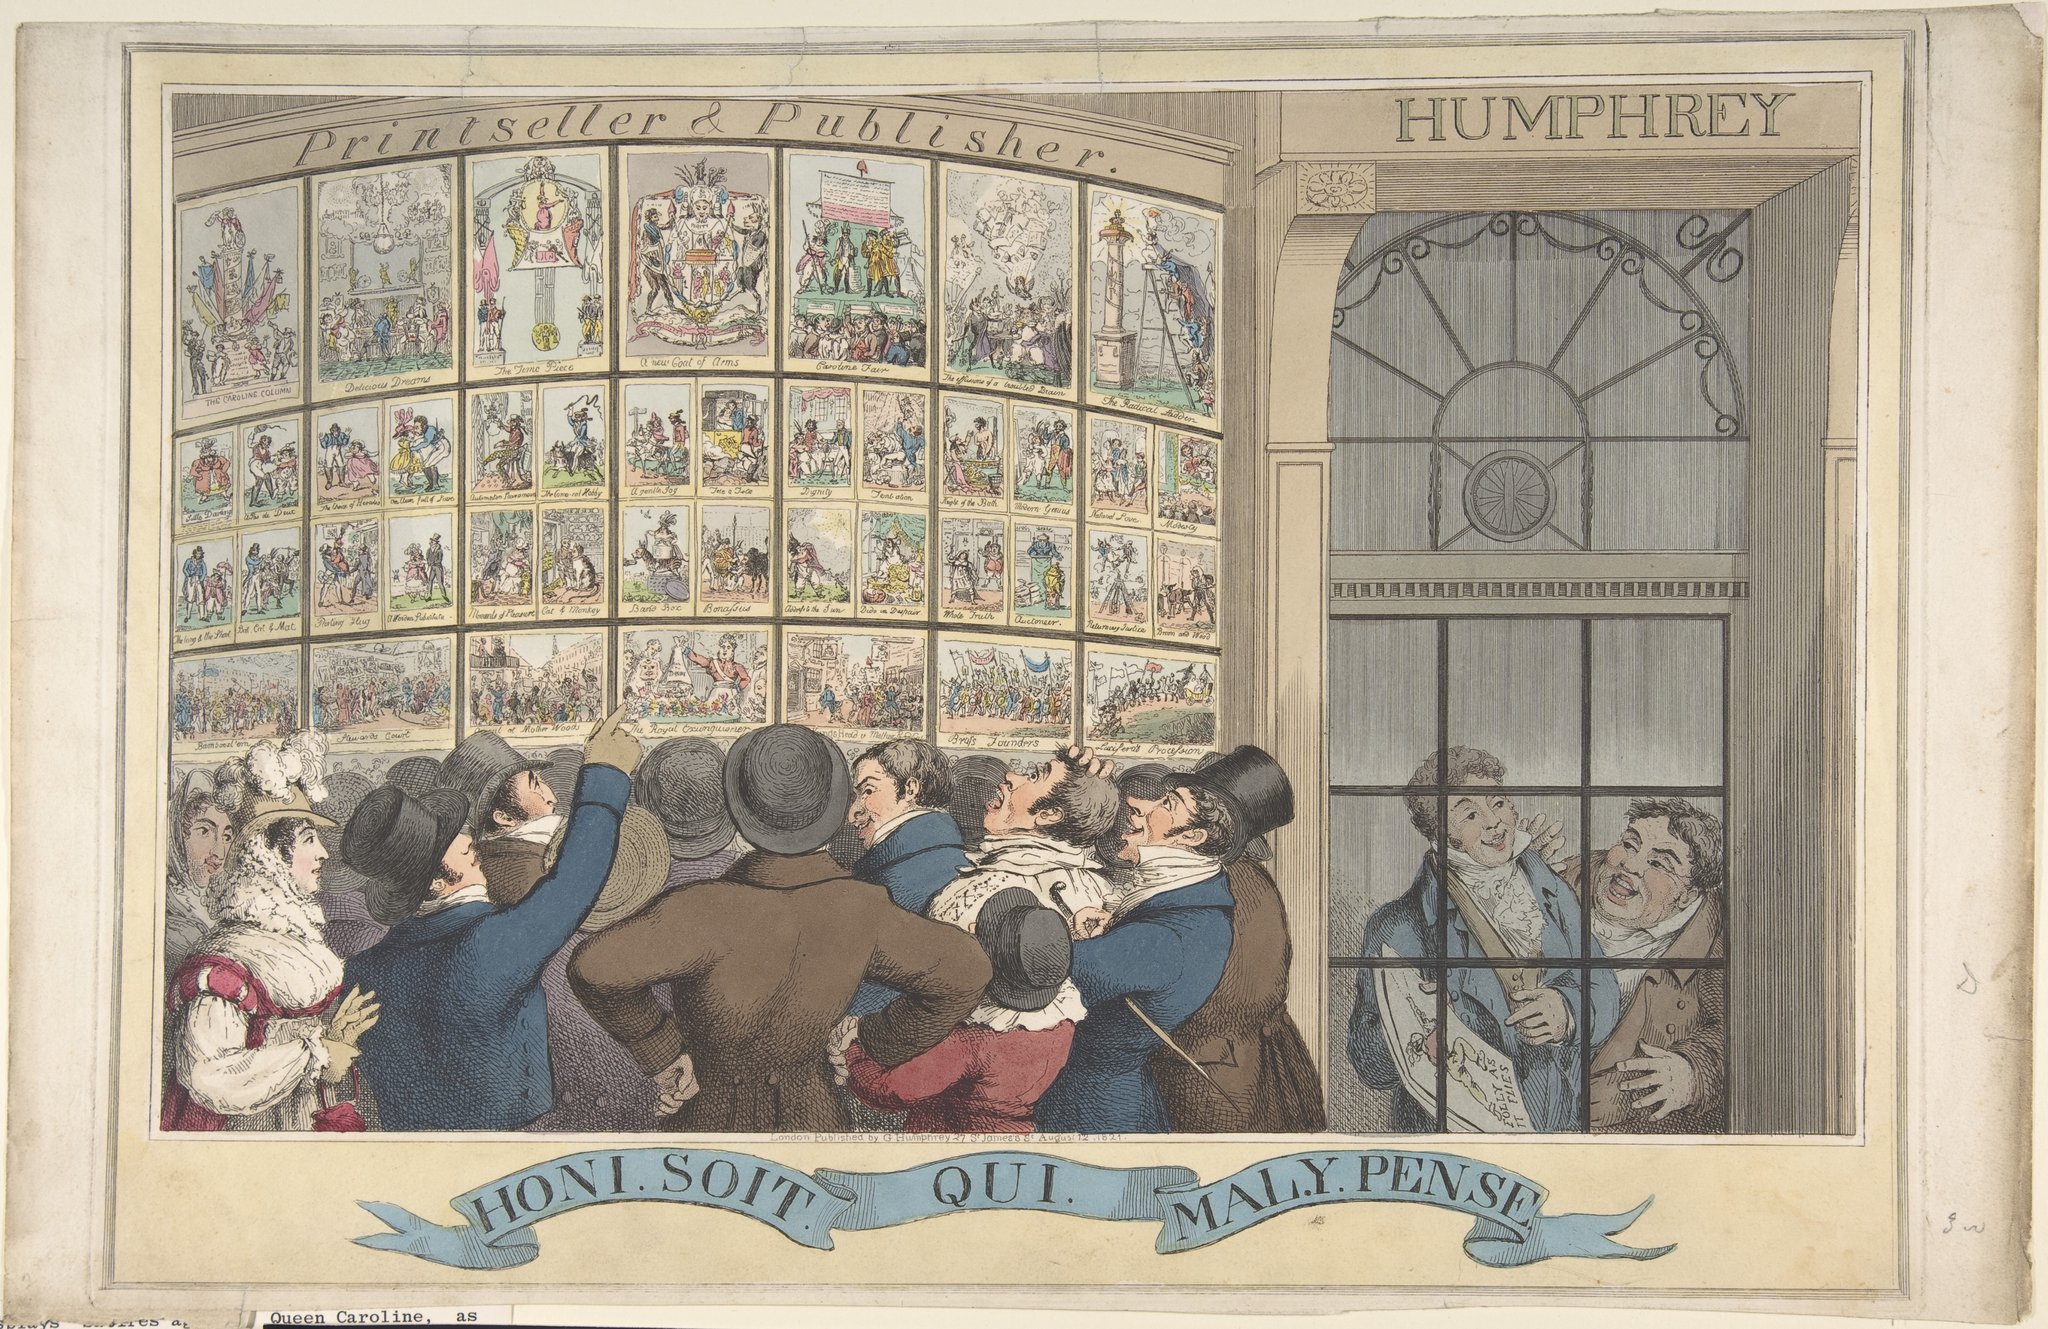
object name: print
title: Honi. Soi. Qui. Mal. Y. Pense: The Caricature Shop of G. Humphrey, 27 St. James's Street, London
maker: theodore lane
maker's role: artist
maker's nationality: british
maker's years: 1800-1828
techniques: etching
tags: spectators,crowd